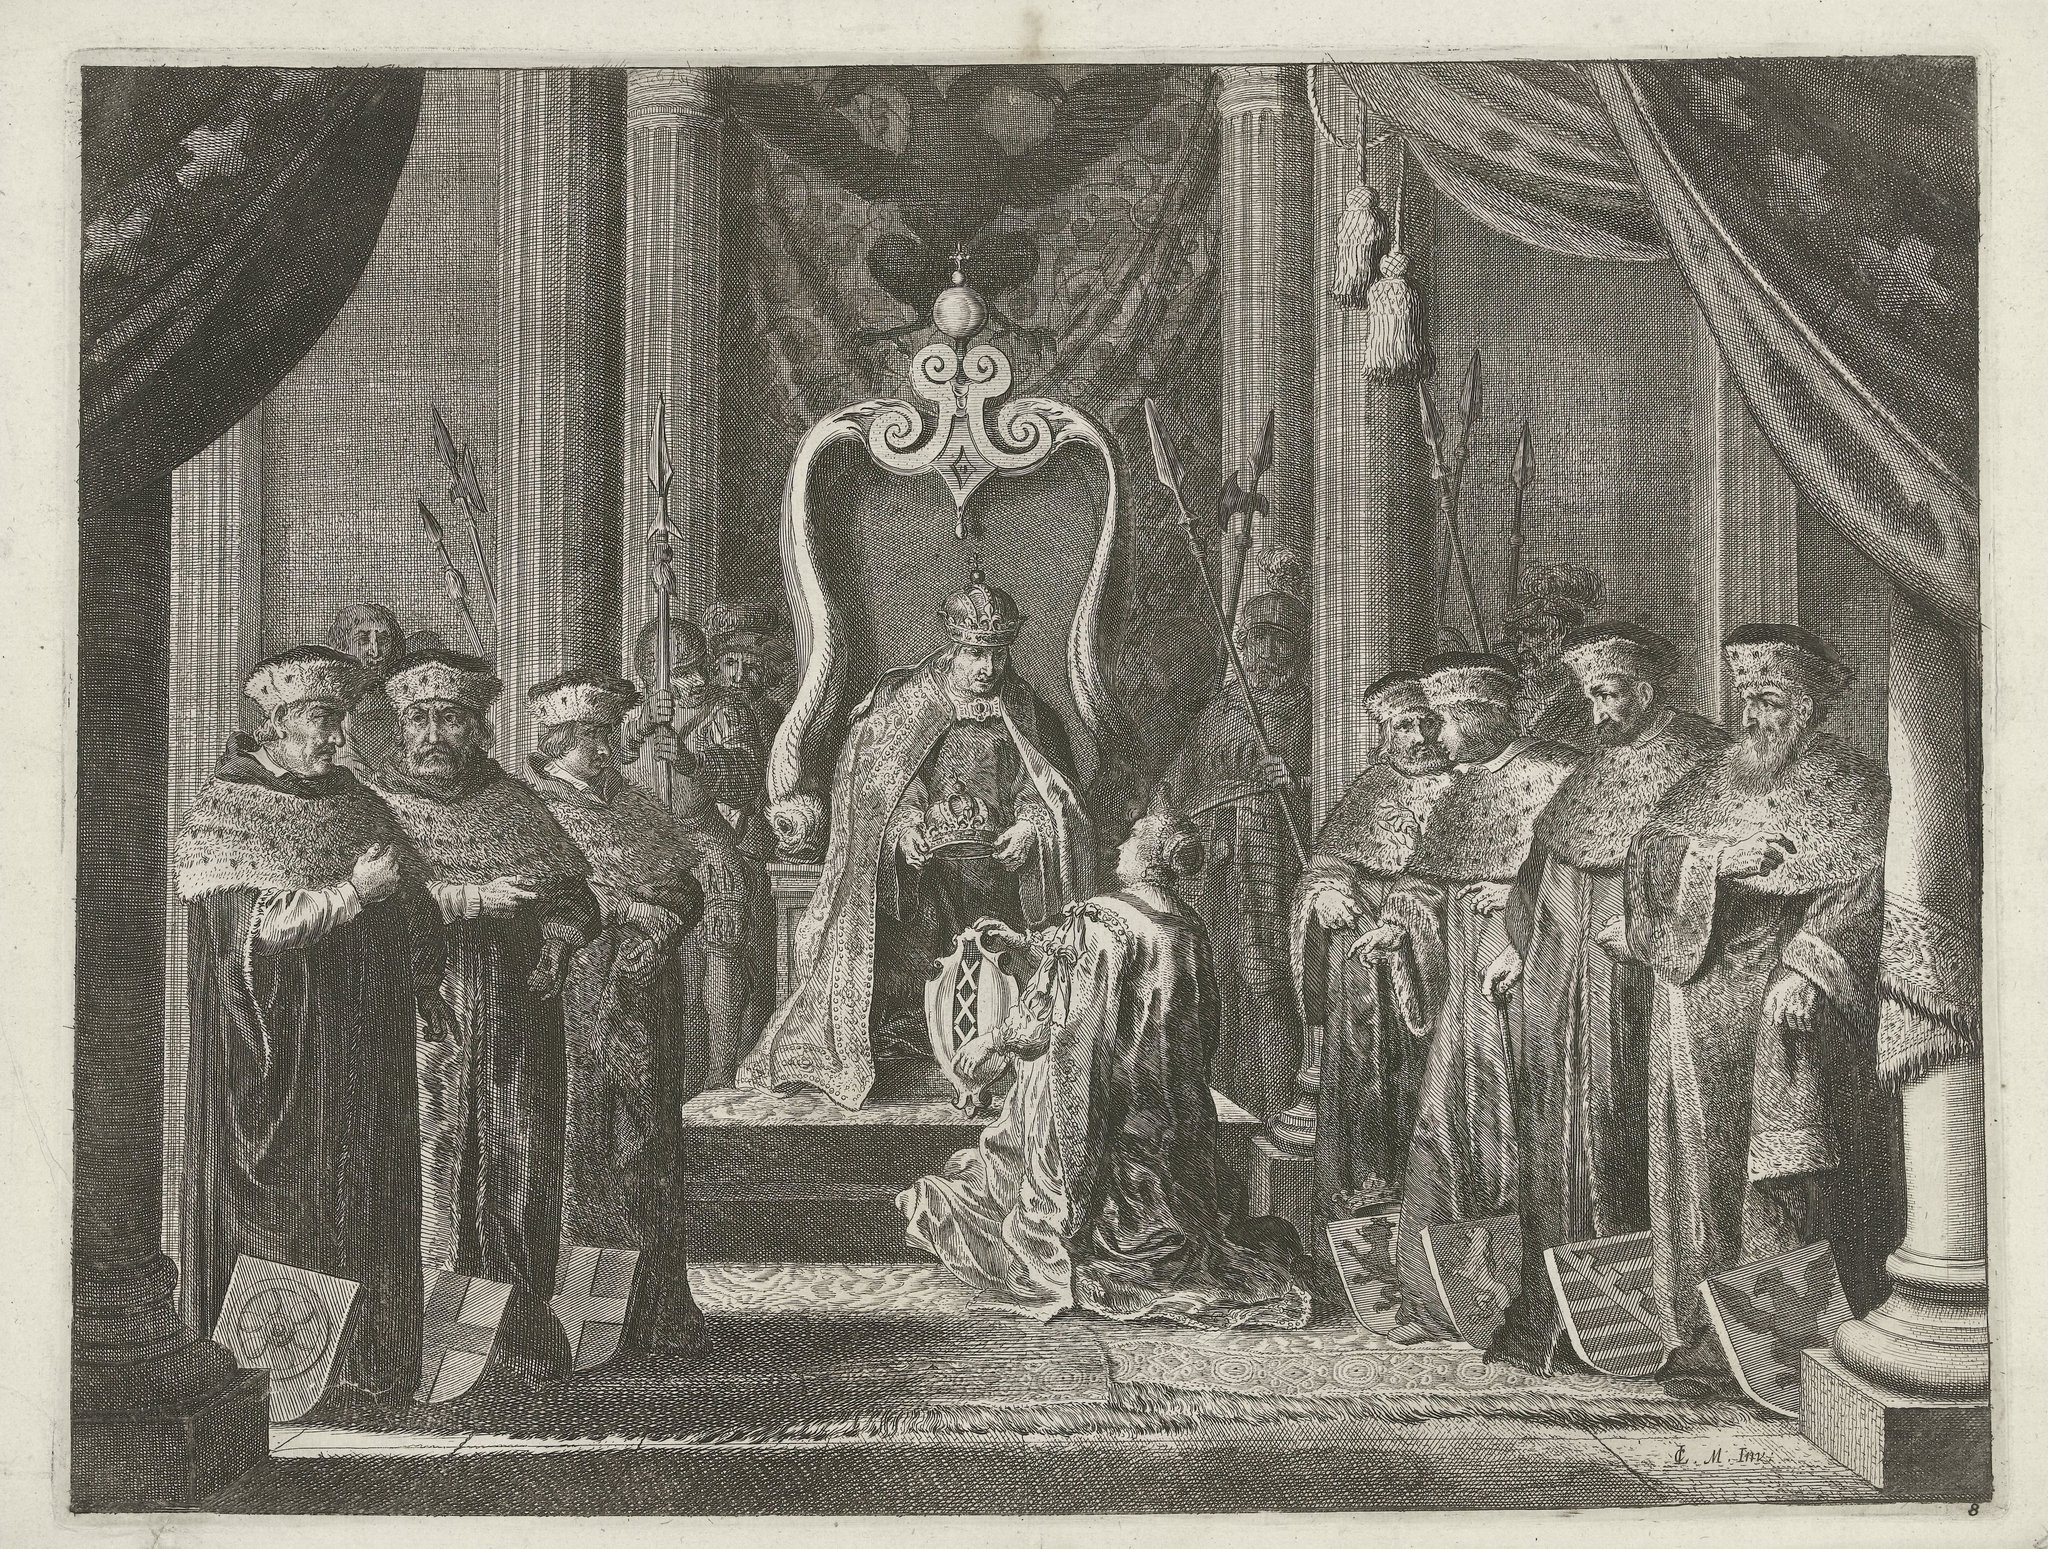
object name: print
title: Feestelijkheden bij het bezoek van Maria de' Medici aan Amsterdam in 1638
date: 1638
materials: paper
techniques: engraving, etching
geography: amsterdam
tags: maximilian i (holy roman emperor), 'tableau vivant', personification of a city, town-patron(ess), triumphal entry and public reception, pageant, 'entrée solennelle', 'joyeuse entrée', amsterdam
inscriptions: collector's mark: Lugt 240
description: Prent ook gebruikt in:* Baerle, Caspar van. Medicea hospes, sive descriptio publicae gratulationis, qua Serenissimam, Augustissimamque Reginam, Mariam de Medicis (…). Amsterdam: Johannes en Cornelis Willemsz. Blaeu, 1638. En in: Baerle, Caspar van. Marie de Medicis, entrant dans Amsterdam : ou, histoire de la reception faicte à la Reyne Mere du Roy tres-Chrestien (…). Amsterdam: Johannes en Cornelis Willemsz. Blaeu, 1638. En in: Baerle, Caspar van en Joost van den Vondel. Blyde inkomst der allerdoorluchtighste koninginne, Maria de Medicis t' Amsterdam. Vertaelt uit het Latijn (…). Amsterdam: Johannes en Cornelis Willemsz. Blaeu, 1639. * Doorgaans zijn de prenten in de bovengenoemde publicaties rechtsonder genummerd (van de huidige prent is dat de derde bekende staat). Maar er zijn ook exemplaren waarin eerdere, ongenummerde, staten van de prenten (van de huidige prent de eerste en tweede bekende staat) zijn ingebonden.